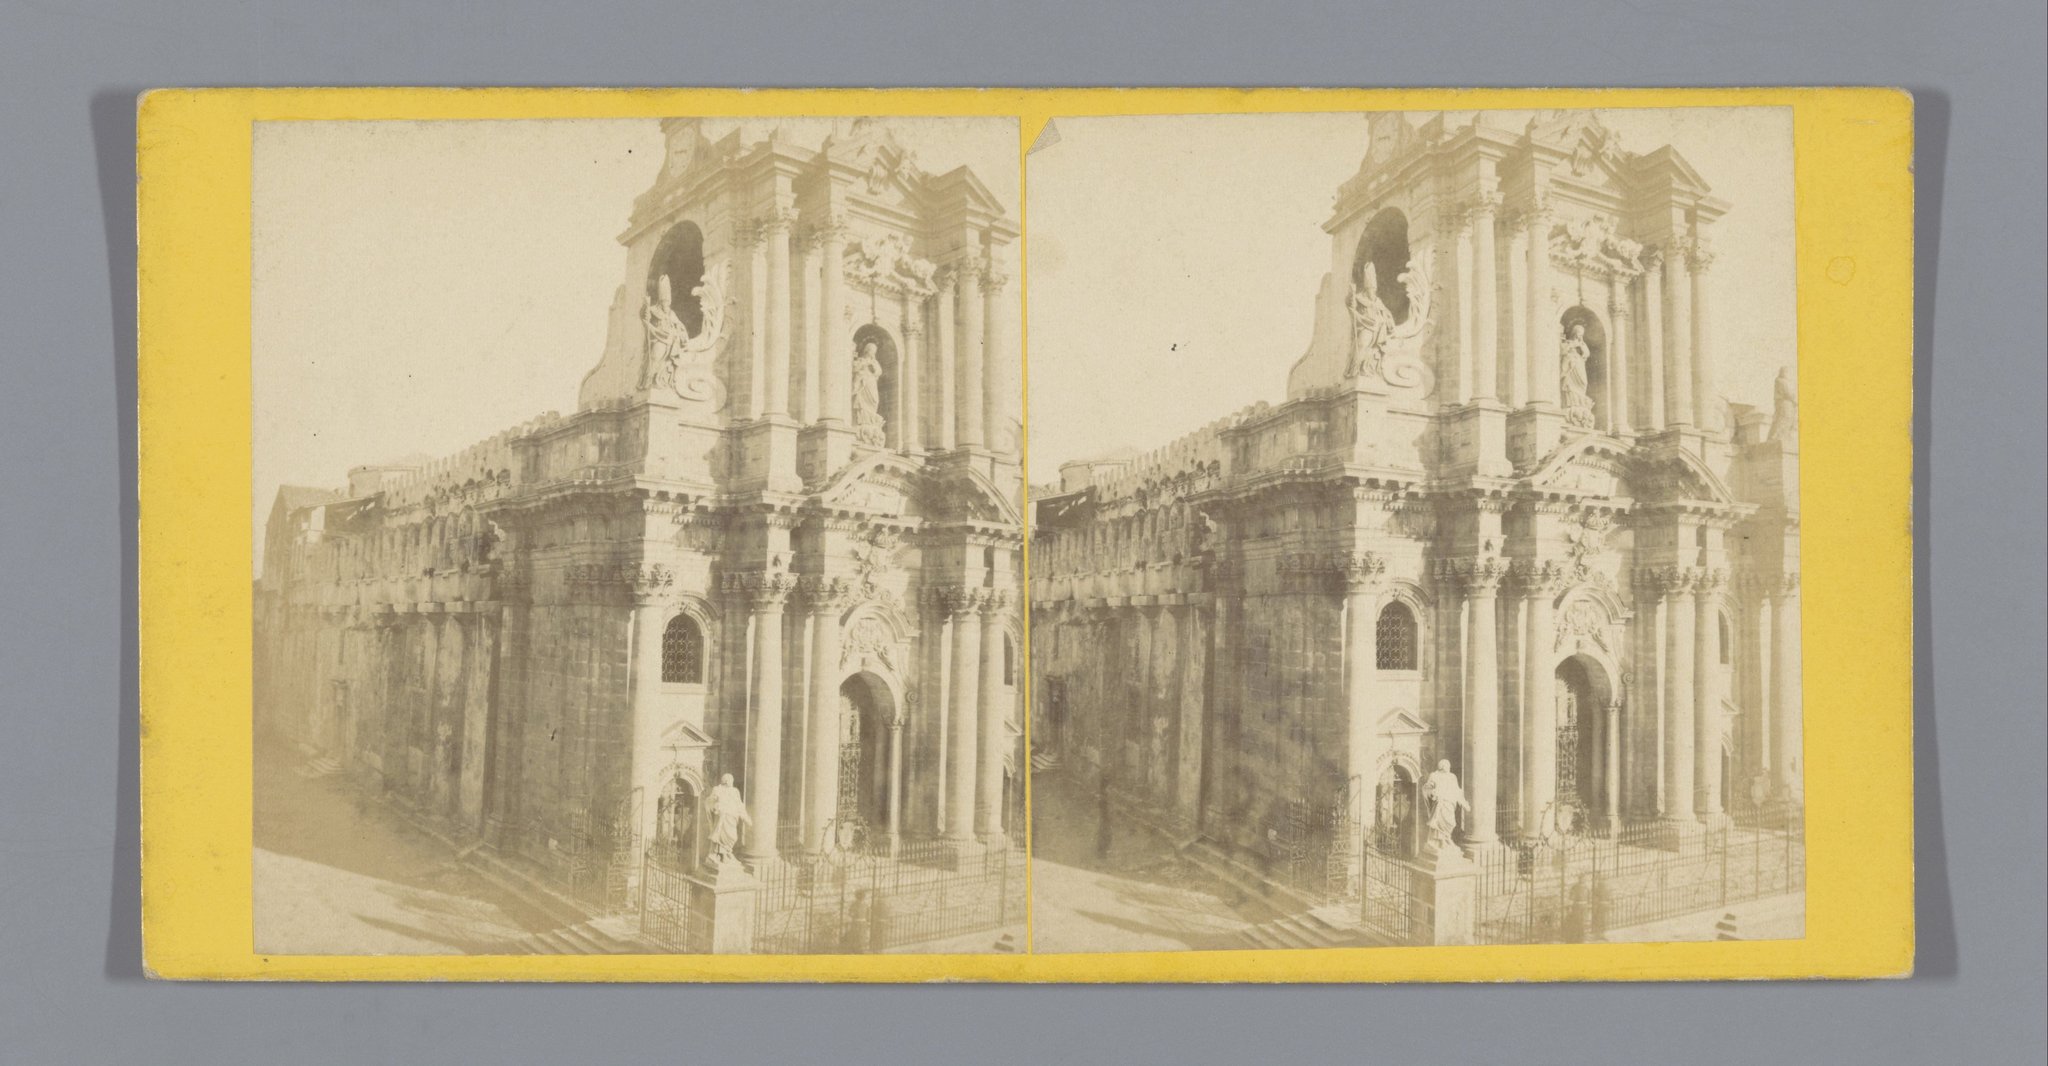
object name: stereograph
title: Temple de Minerve (Cathédrale) (Syracuse)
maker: Anonymous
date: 1850-1880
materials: cardboard, photographic support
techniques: albumen print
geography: syracuse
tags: church (exterior)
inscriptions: number: ‘1366.’